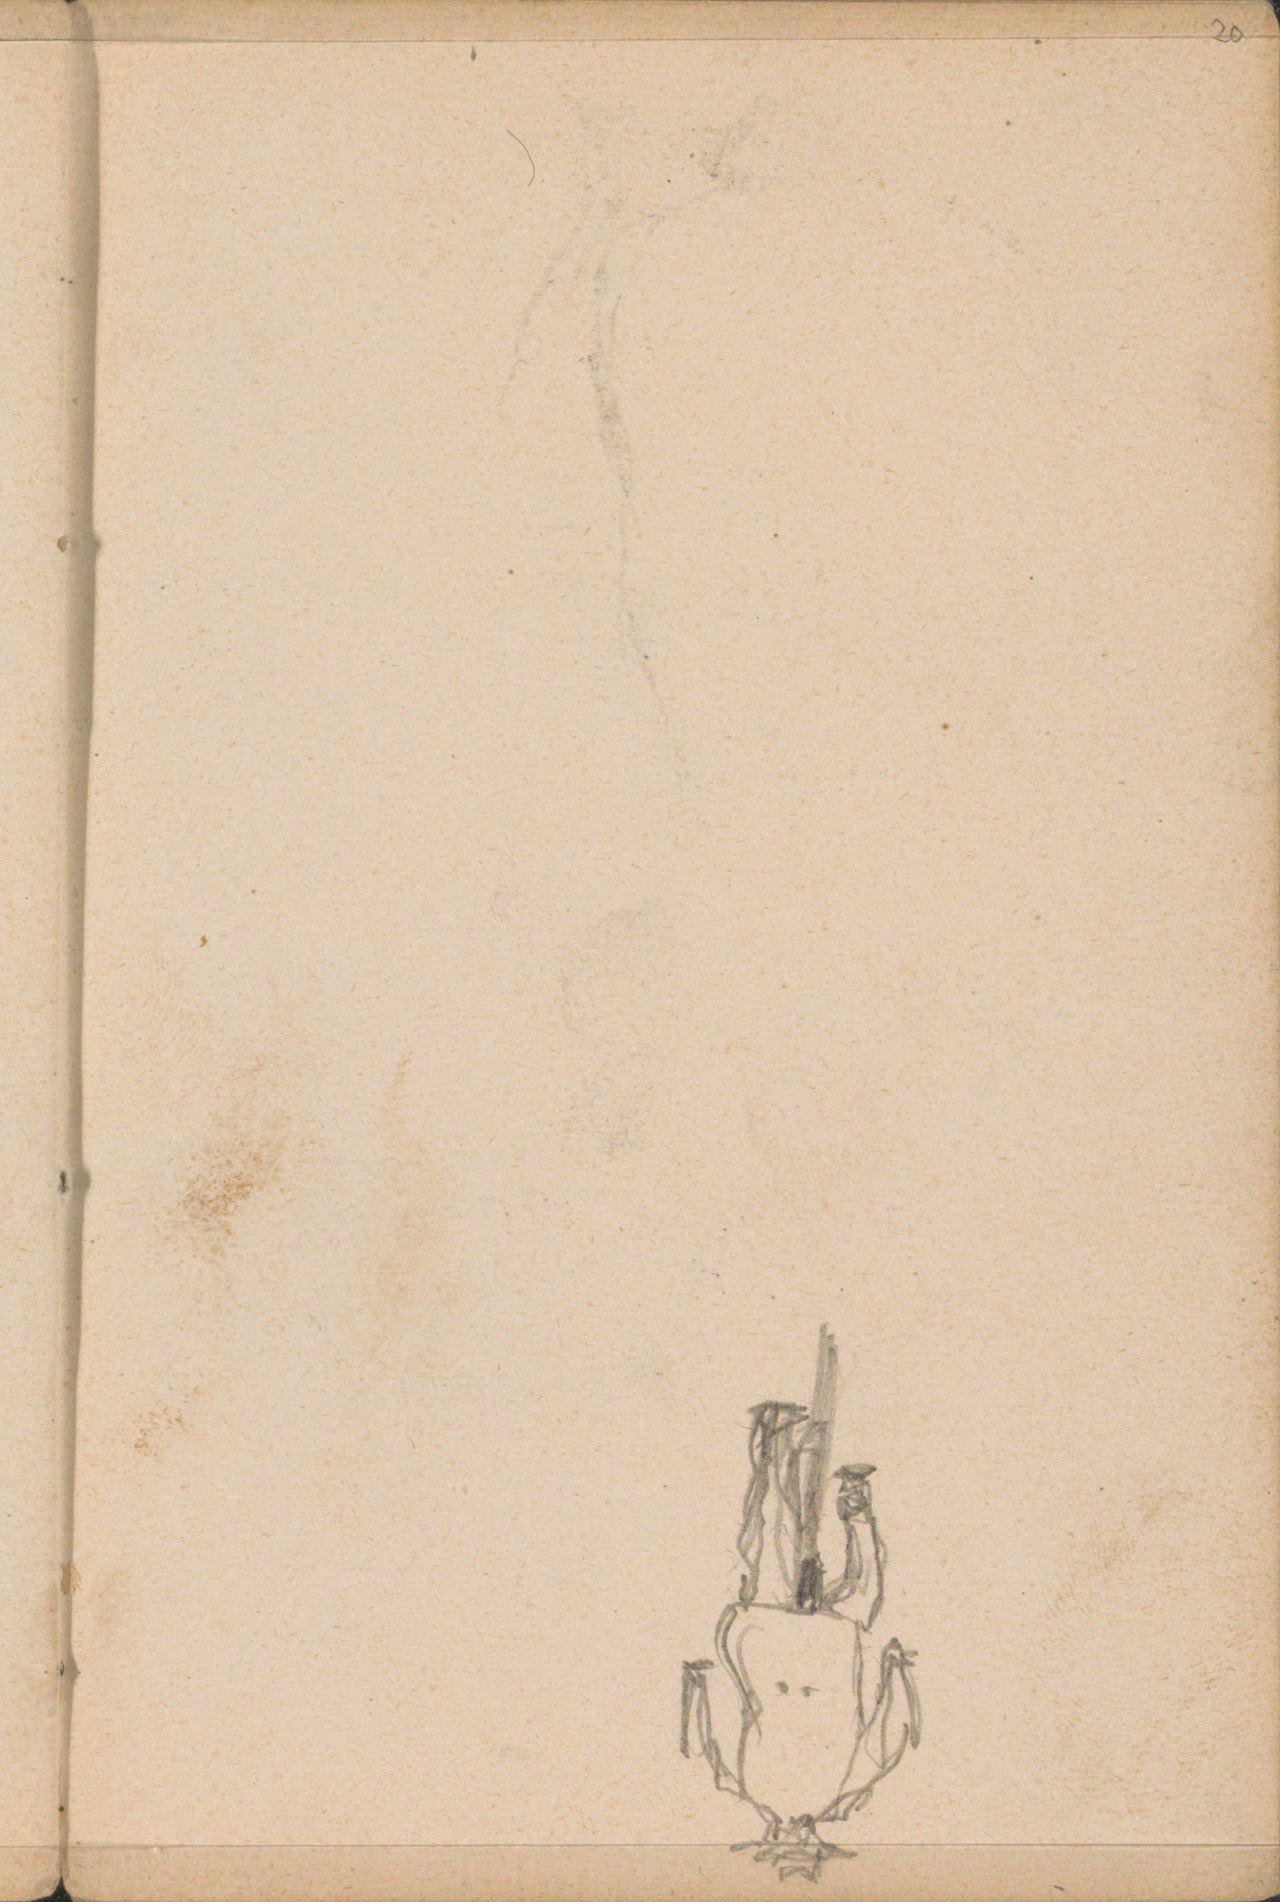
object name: sketchbook leaf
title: Man op een fiets, op de rug gezien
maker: george hendrik breitner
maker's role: draughtsman, painter, print maker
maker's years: 1857-1923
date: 1903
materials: paper, pencil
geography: amsterdam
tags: riding, cycling (recreation), adult man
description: Man op een fiets, op de rug gezien. Pagina 20 uit een schetsboek met 46 bladen.